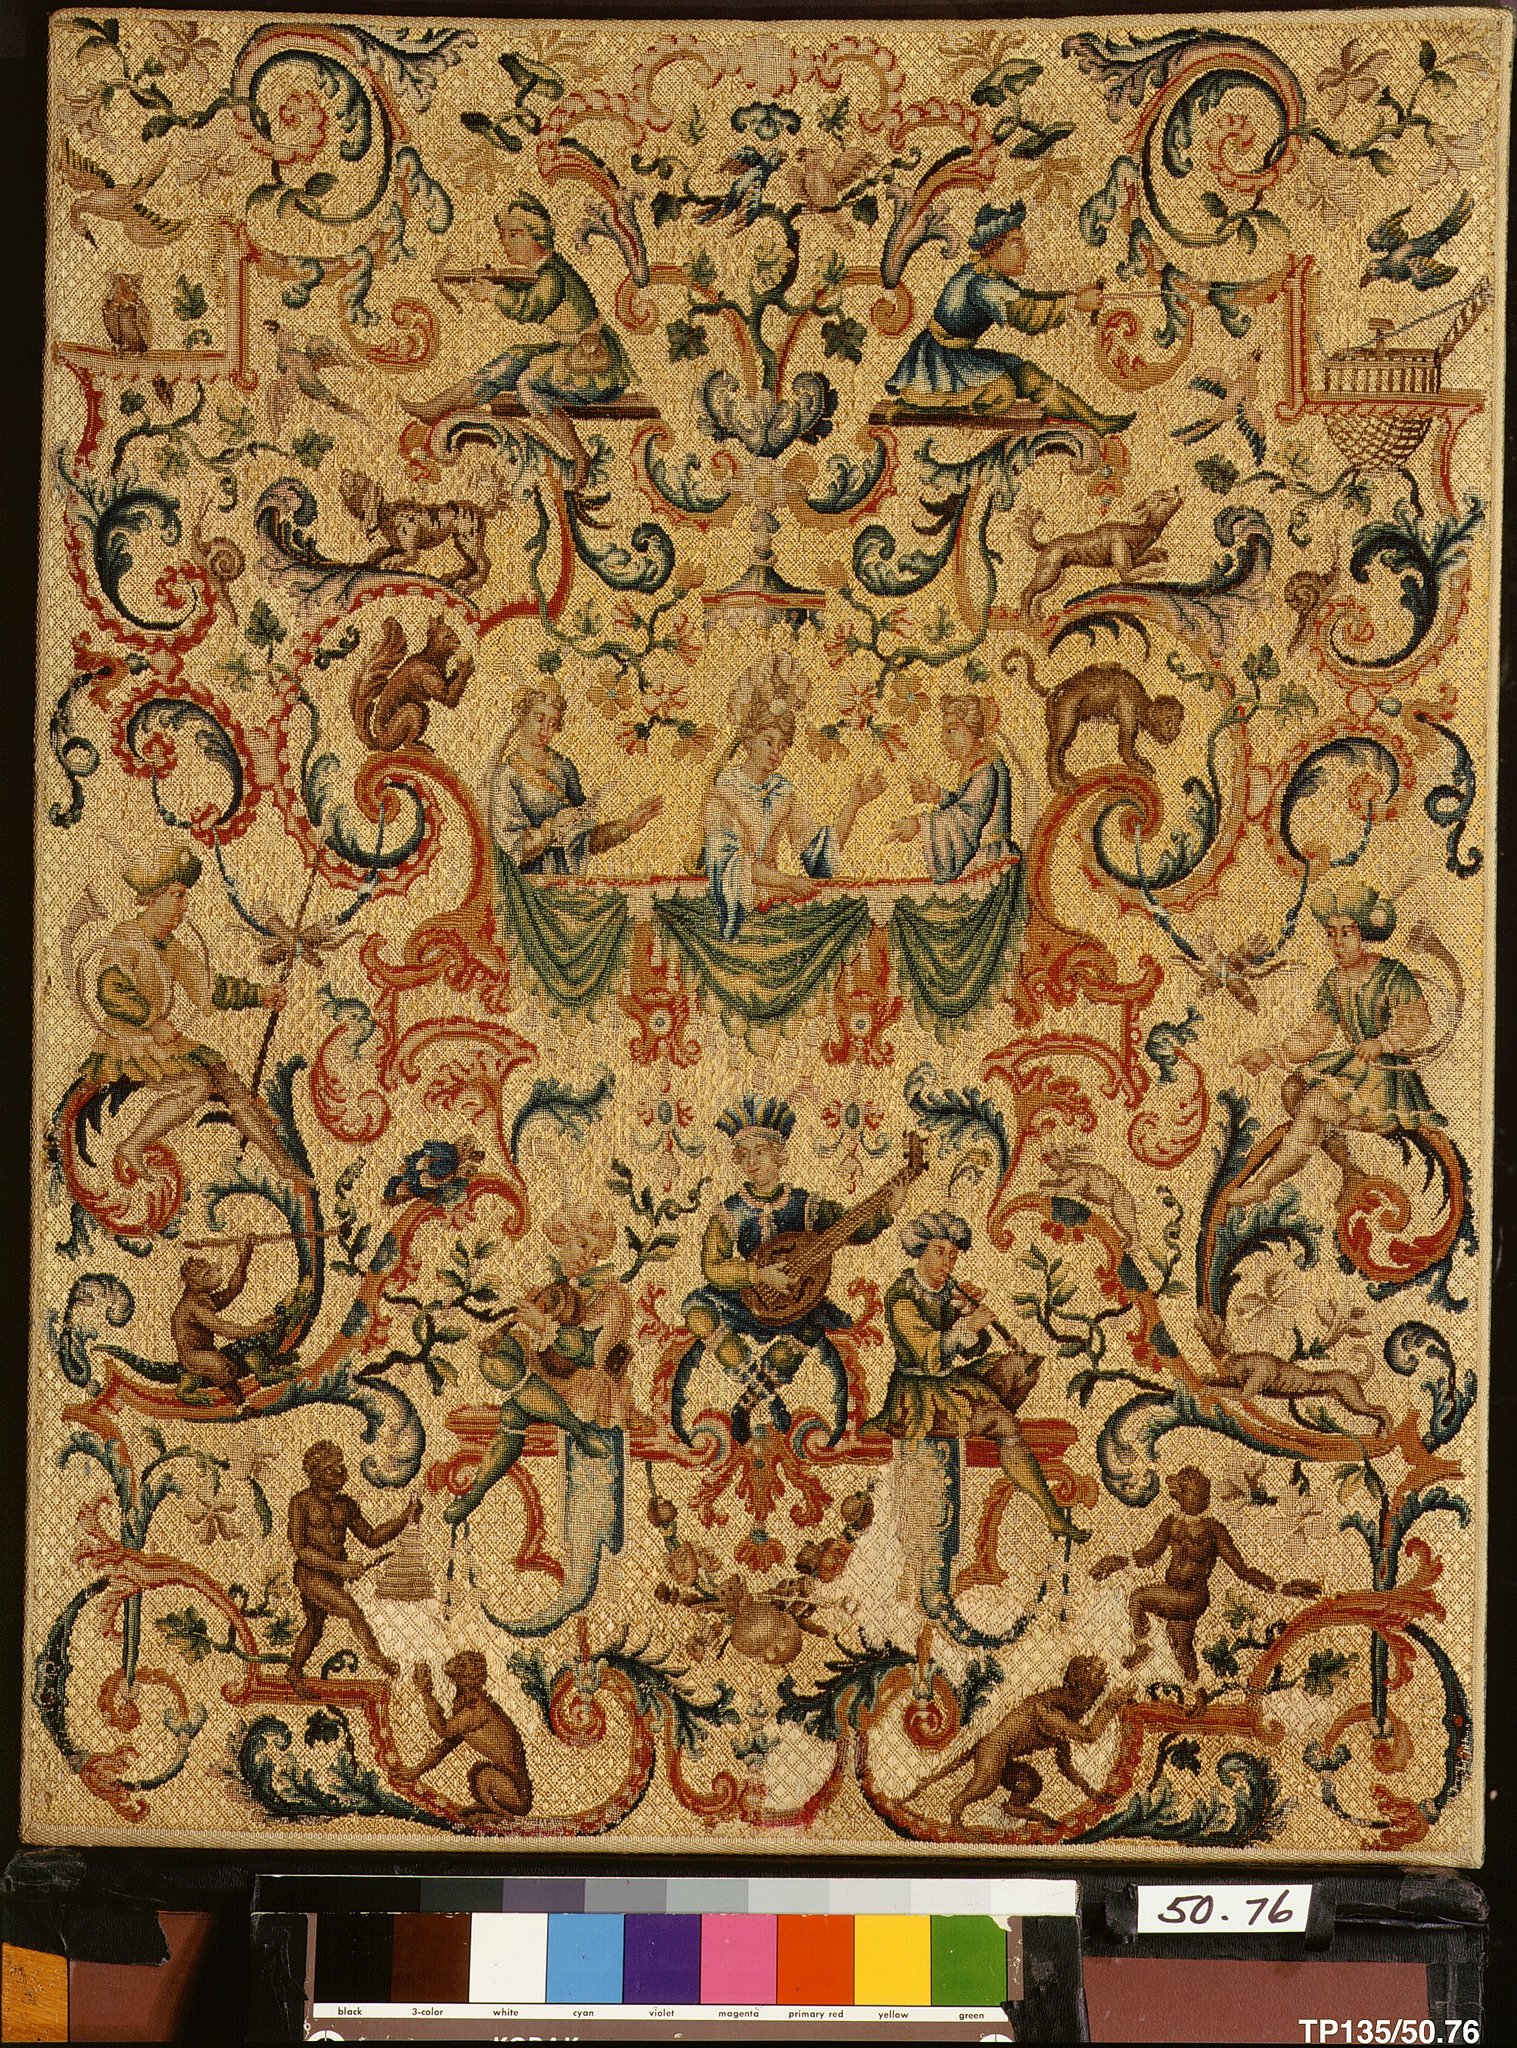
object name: fire screen panel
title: Panel for a fire screen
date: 1667-1733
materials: canvas, silk, wool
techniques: embroidery, relief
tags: musical instruments,birds,men,women,dogs,monkeys